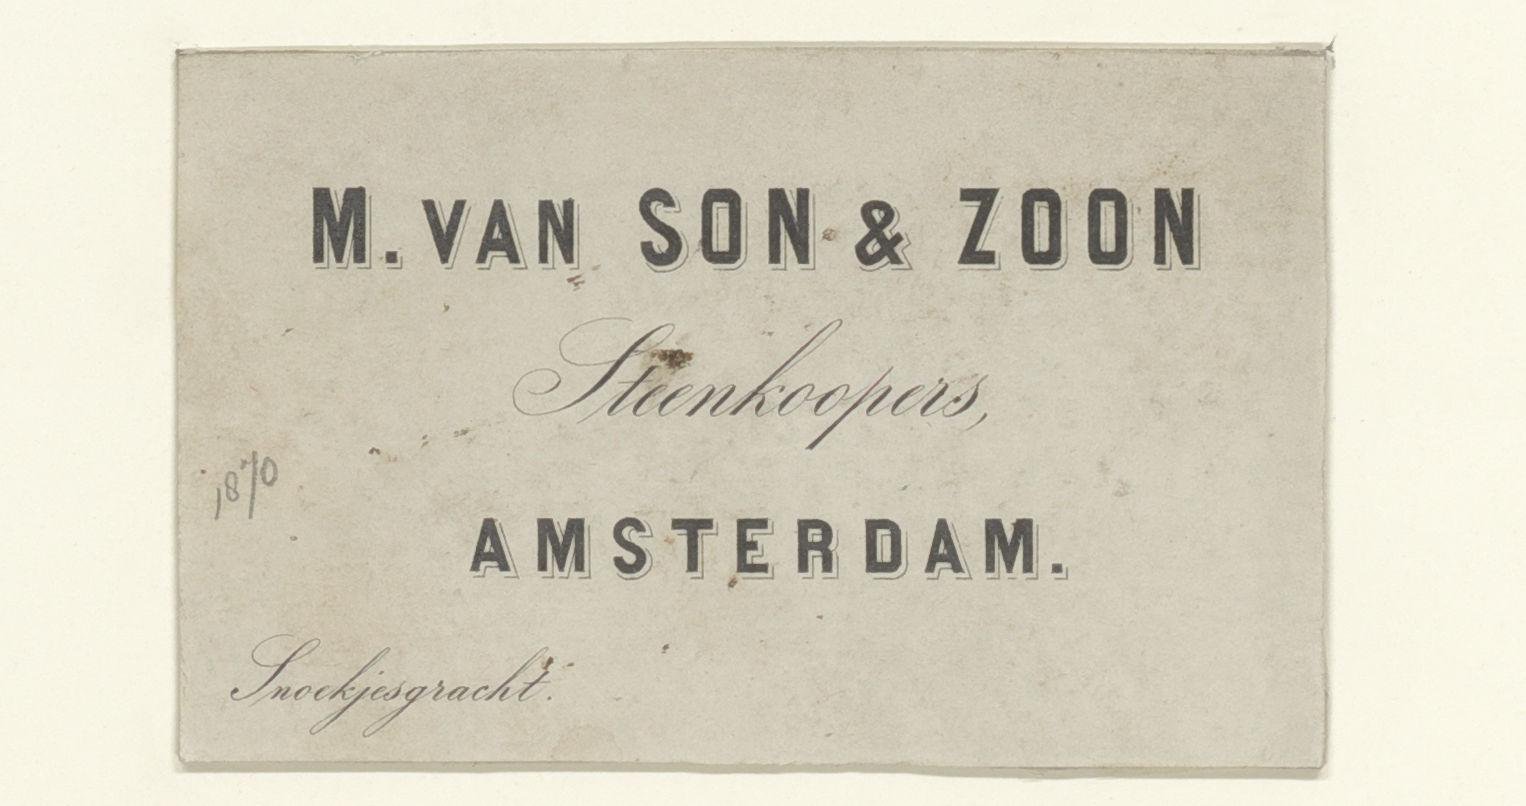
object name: text sheet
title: Visitekaartje van M. van Son & Zoon Steenkoopers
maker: Anonymous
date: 1870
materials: paper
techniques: letterpress printing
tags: amsterdam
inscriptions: stamp, collector's mark: Lugt 1641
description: Visitekaartje van M. van Son & Zoon Steenkoopers. Onderwerpsrubrieken binnen de Atlas Zeden en Gewoonten: Handel, nijverheid en verkeer, Koophandel, Veilingen, Makelaardij en Verzekeringswezen, Oude adreskaarten van winkels en fabrieken, reclame.